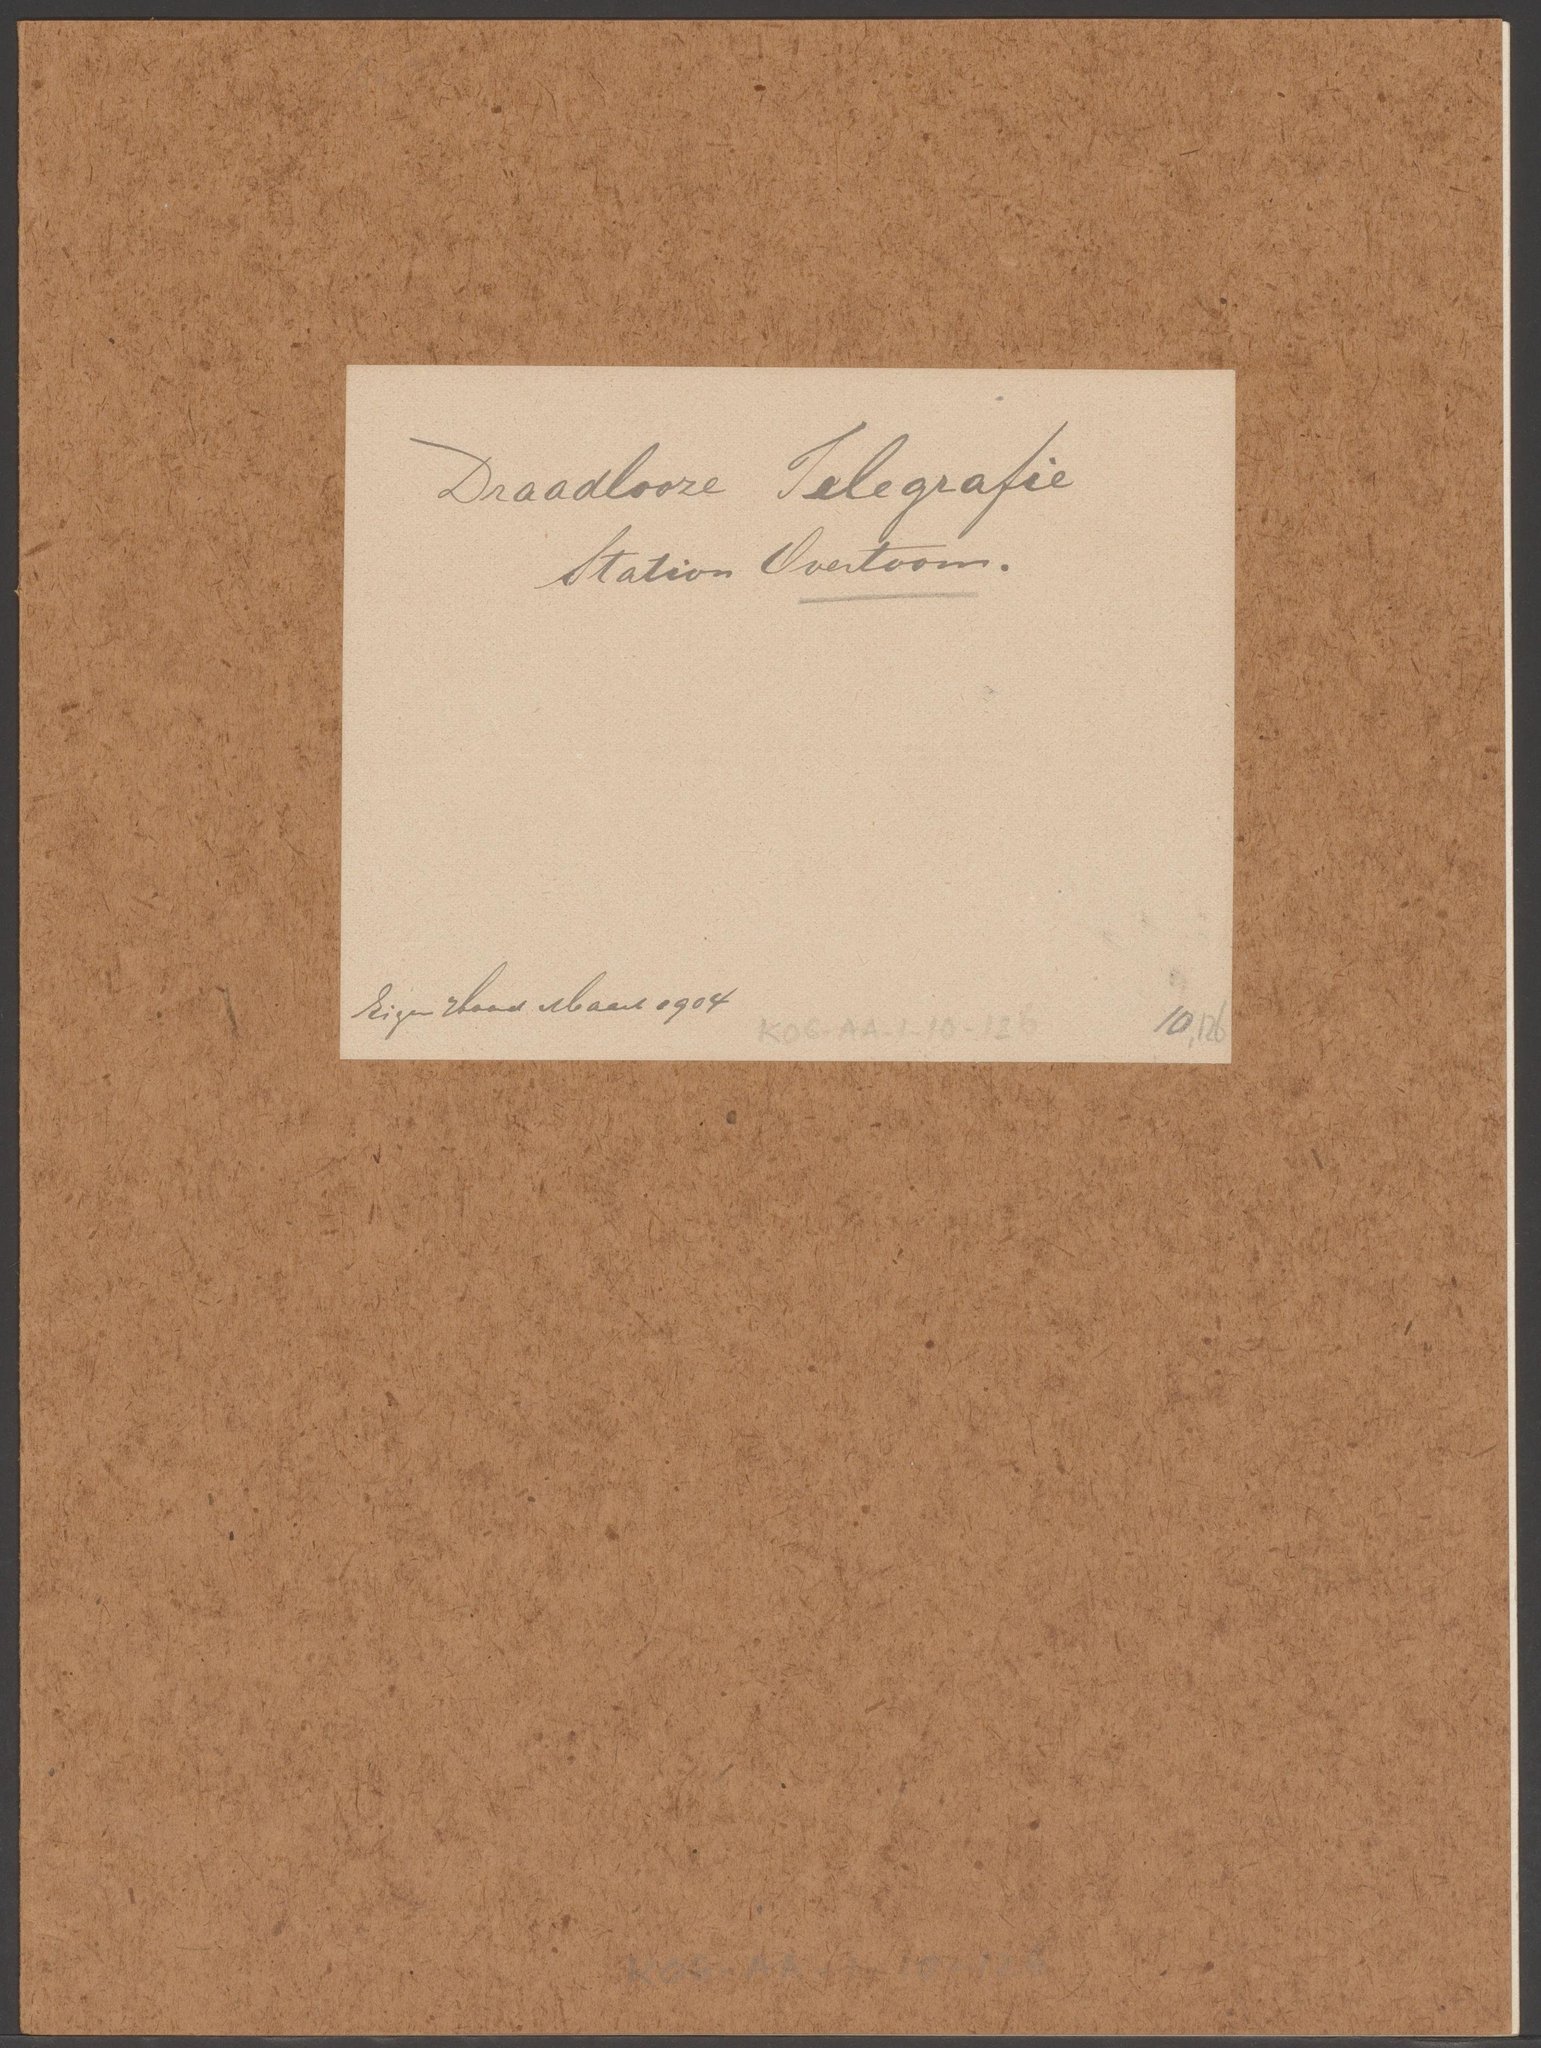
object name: page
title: Bladzijden uit Eigen Haard over het draadloze telegrafie station aan de Overtoom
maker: Anonymous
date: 1903-1904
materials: paper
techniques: letterpress printing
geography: haarlem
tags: city-view in general; 'veduta', (morse) telegraph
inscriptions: inscription: ‘Draadloze Telegrafie / Station Overtoom / Eigen Haard Maart 1904’, collector's mark: ‘5’ Lugt 1641b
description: Onderwerpsrubriek binnen de Atlas Amsterdam: Overtoom. Twaalf bladzijden uit Eigen Haard van maart 1904.